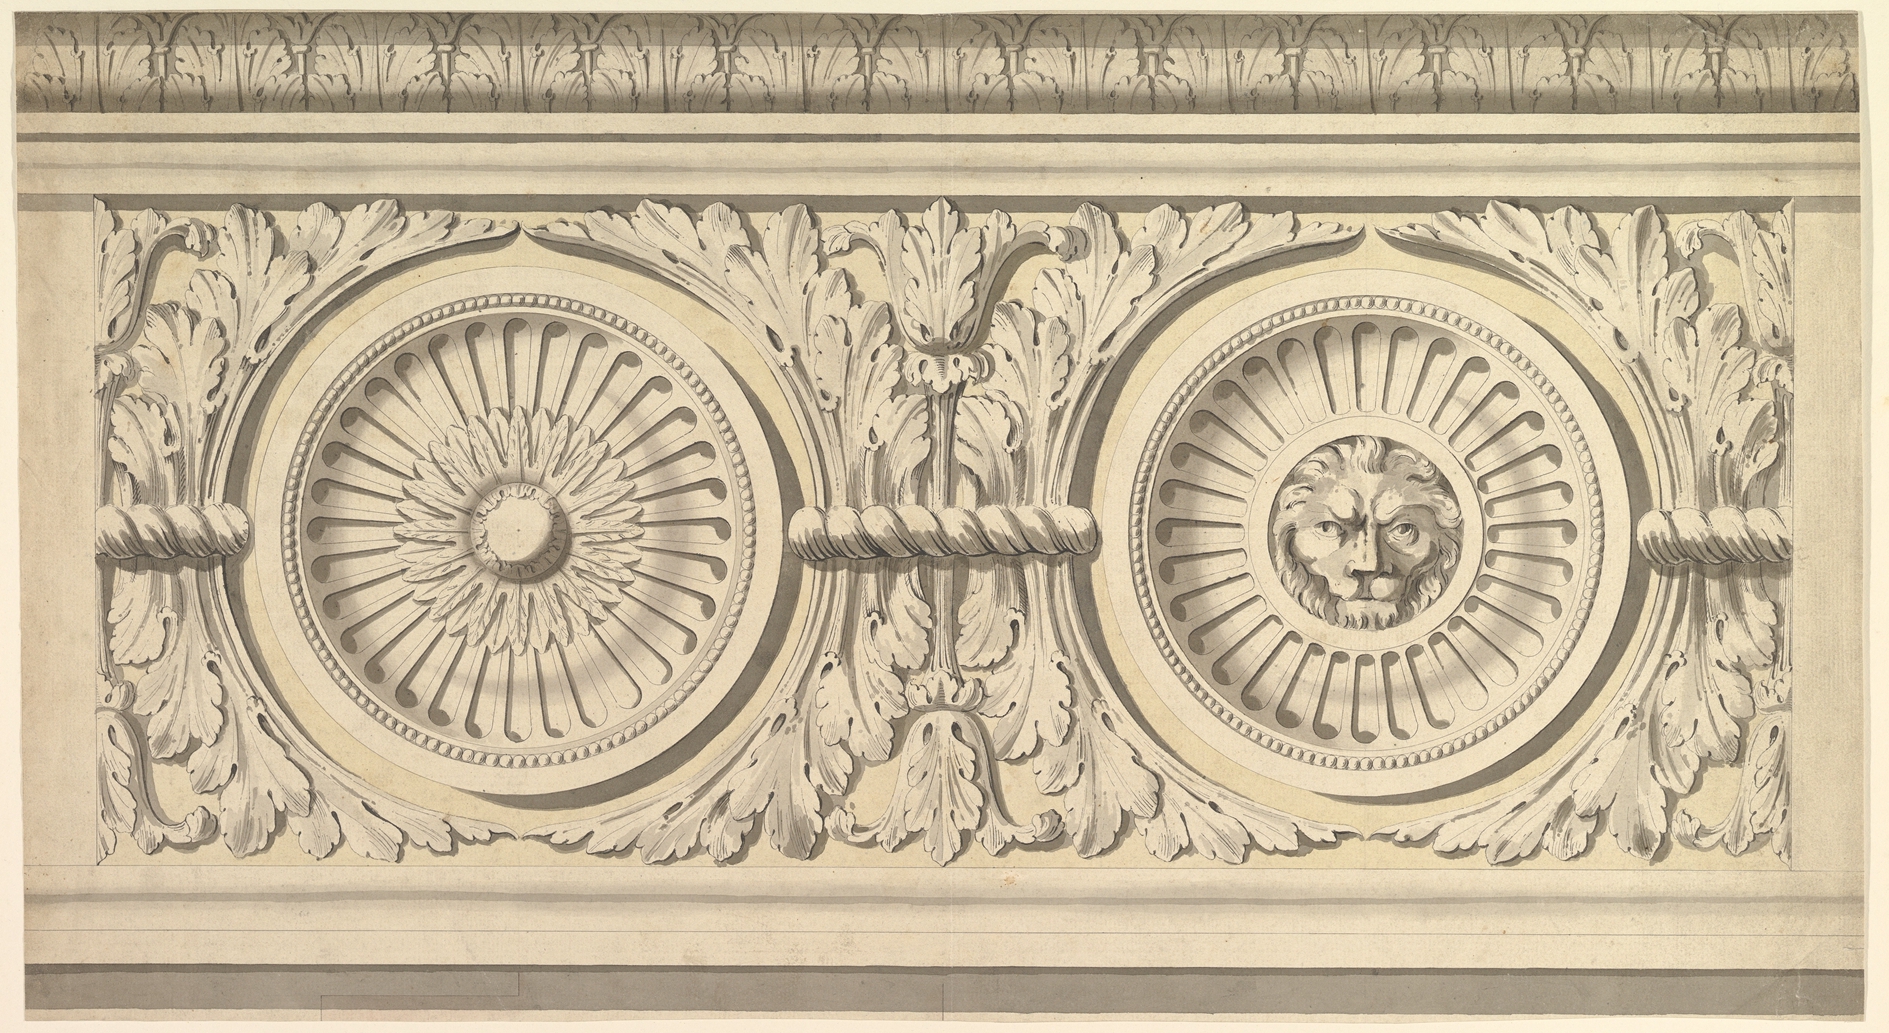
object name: drawing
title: Design for a Frieze, Ornamented with Lion's Head Paterae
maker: john yenn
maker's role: artist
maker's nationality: british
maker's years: 1750-1821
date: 1767-1833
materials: ink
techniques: brush, pen, wash